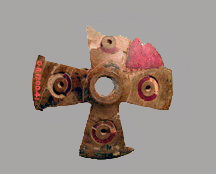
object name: disk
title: Ivory and amber ornament on bronze surface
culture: etruscan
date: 700-501 BCE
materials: amber, bronze, ivory